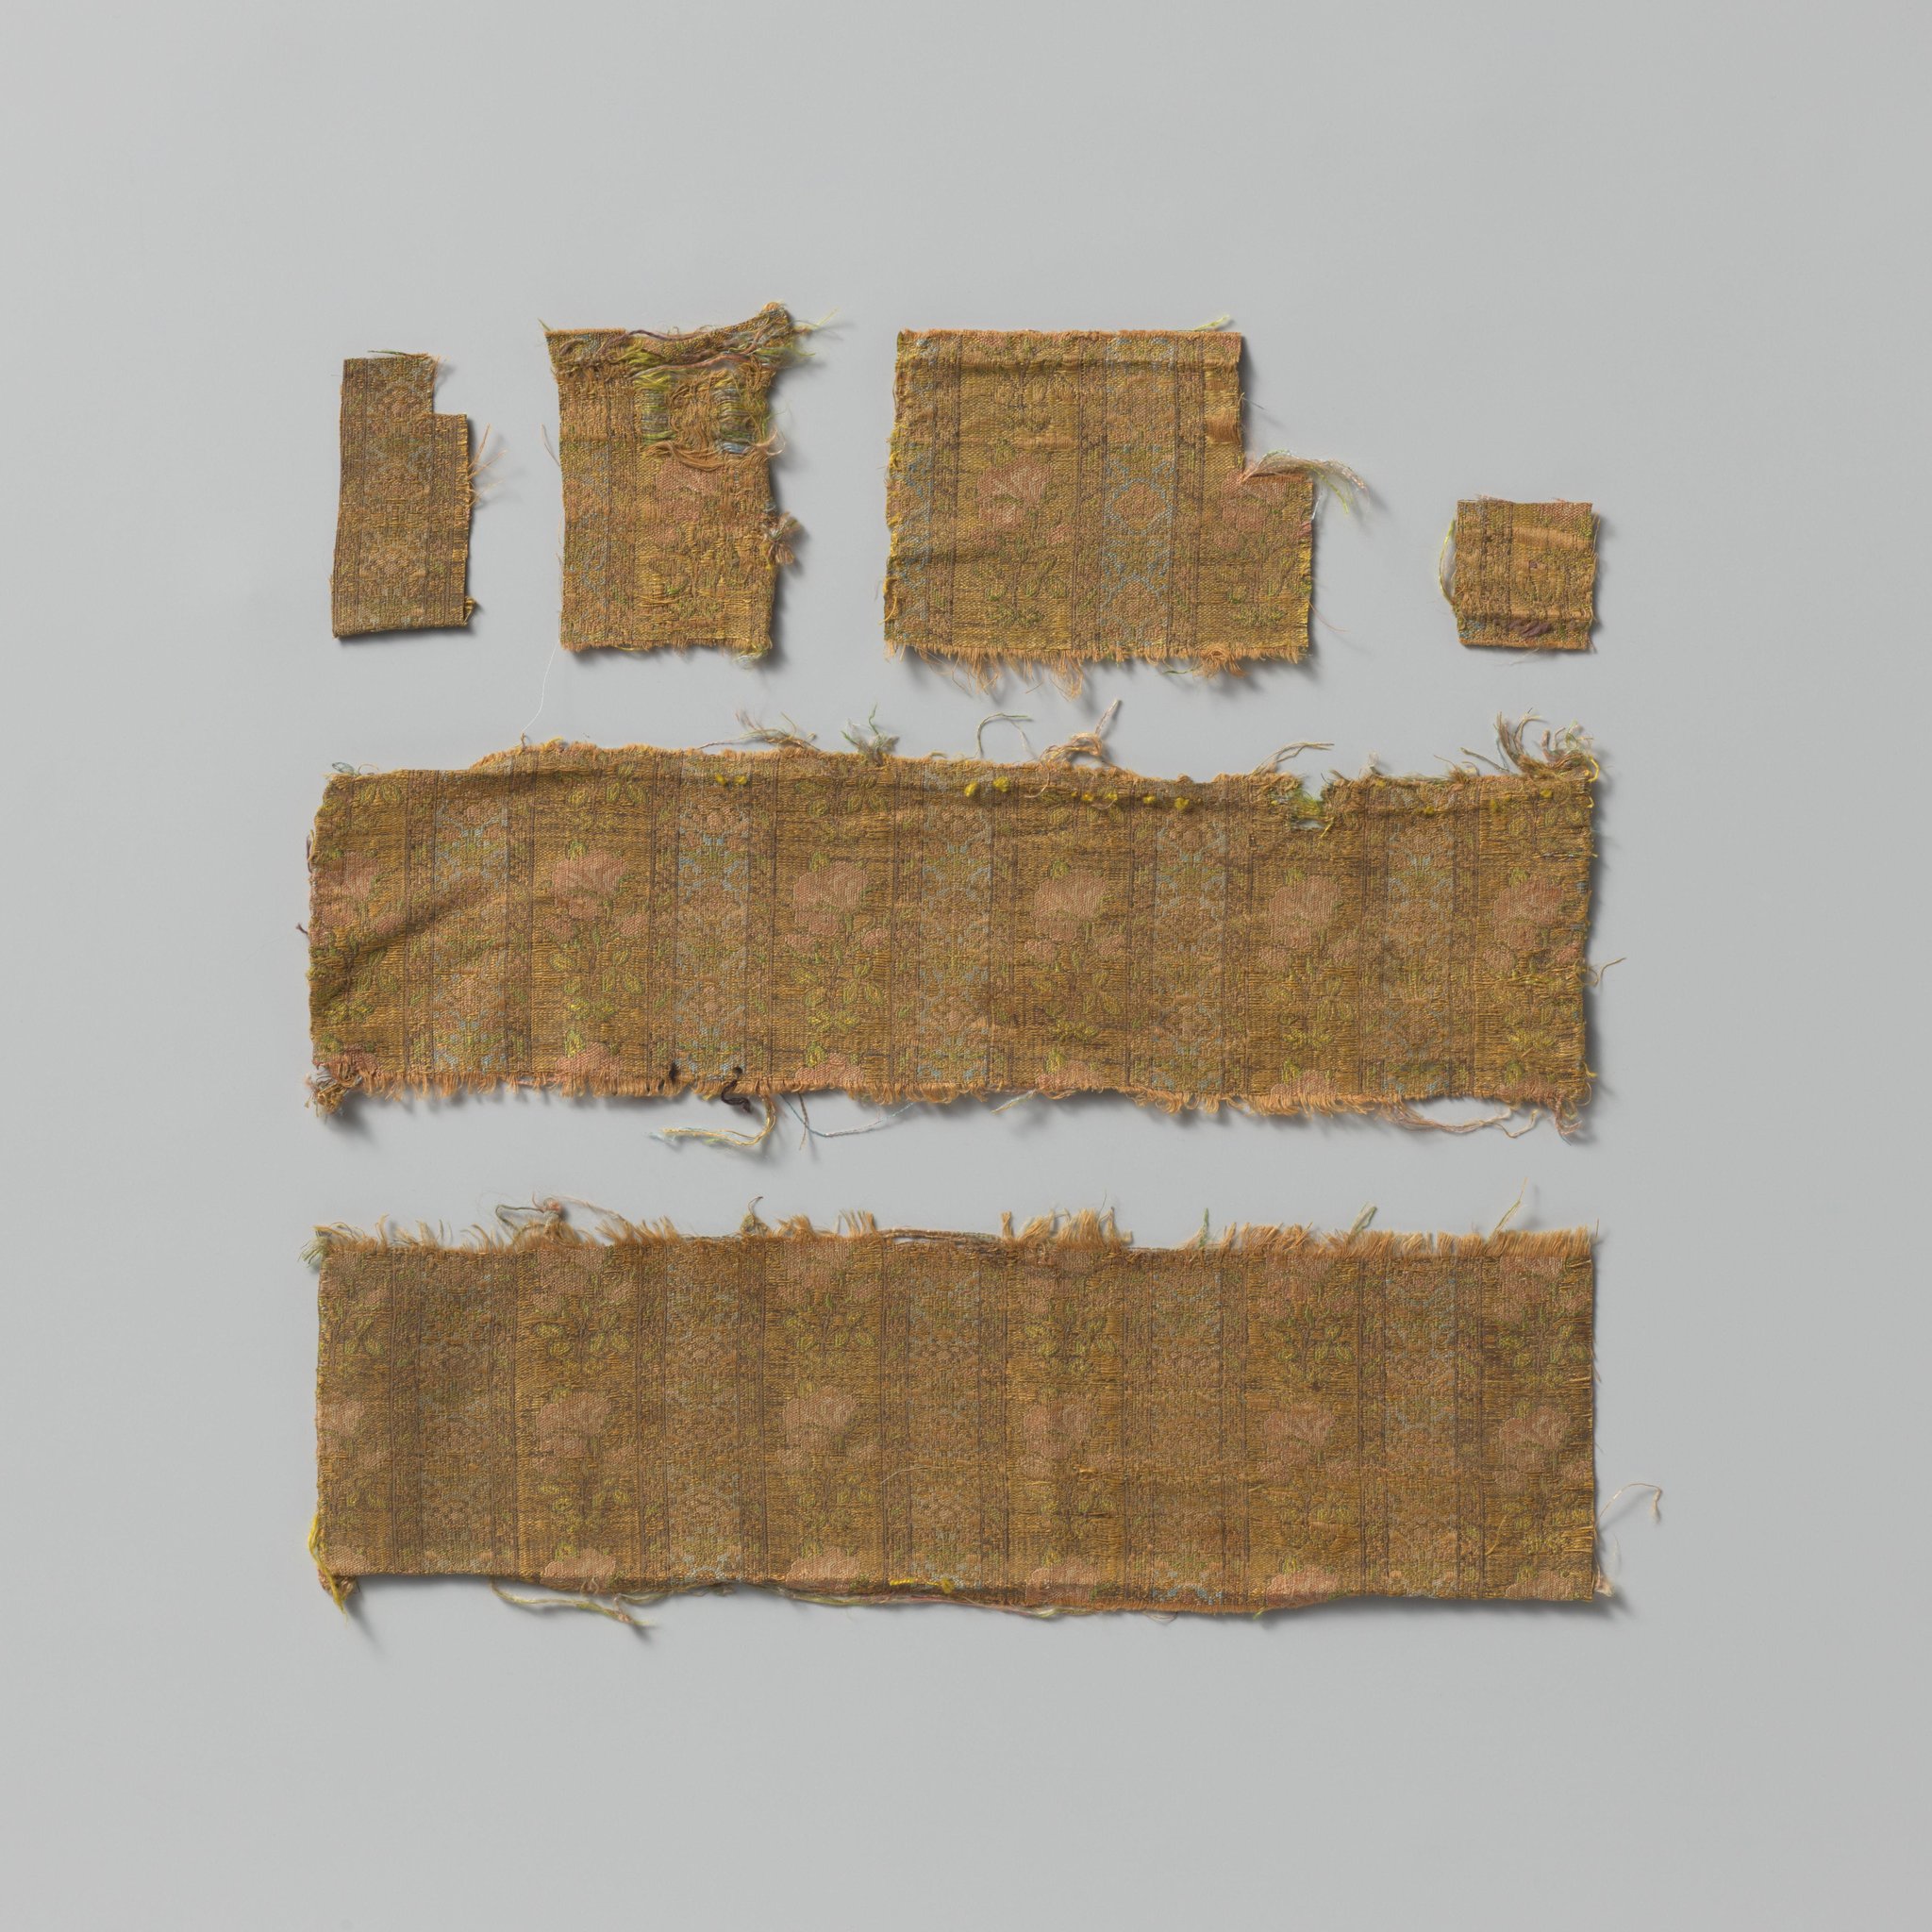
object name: zijdebrokaat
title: Fragment zijden brokaatweefsel met een patroon van pastelkleurige bloemen op gestreepte grond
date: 1600-1800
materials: silk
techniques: brocade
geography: iran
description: Fragment zijden brokaatweefsel met een patroon van pastelkleurige bloemen op gestreepte grond. Patroon: verticale zilveren banen (vergaan tot op de gele kern) afgewisseld met smalle lichtblauwe banen in grijs-beige lijstwerk. Vulling van gebogen bloemtakken en stijve palmetbloemen in roze met wit en roze met zilver. Oosters textiel.